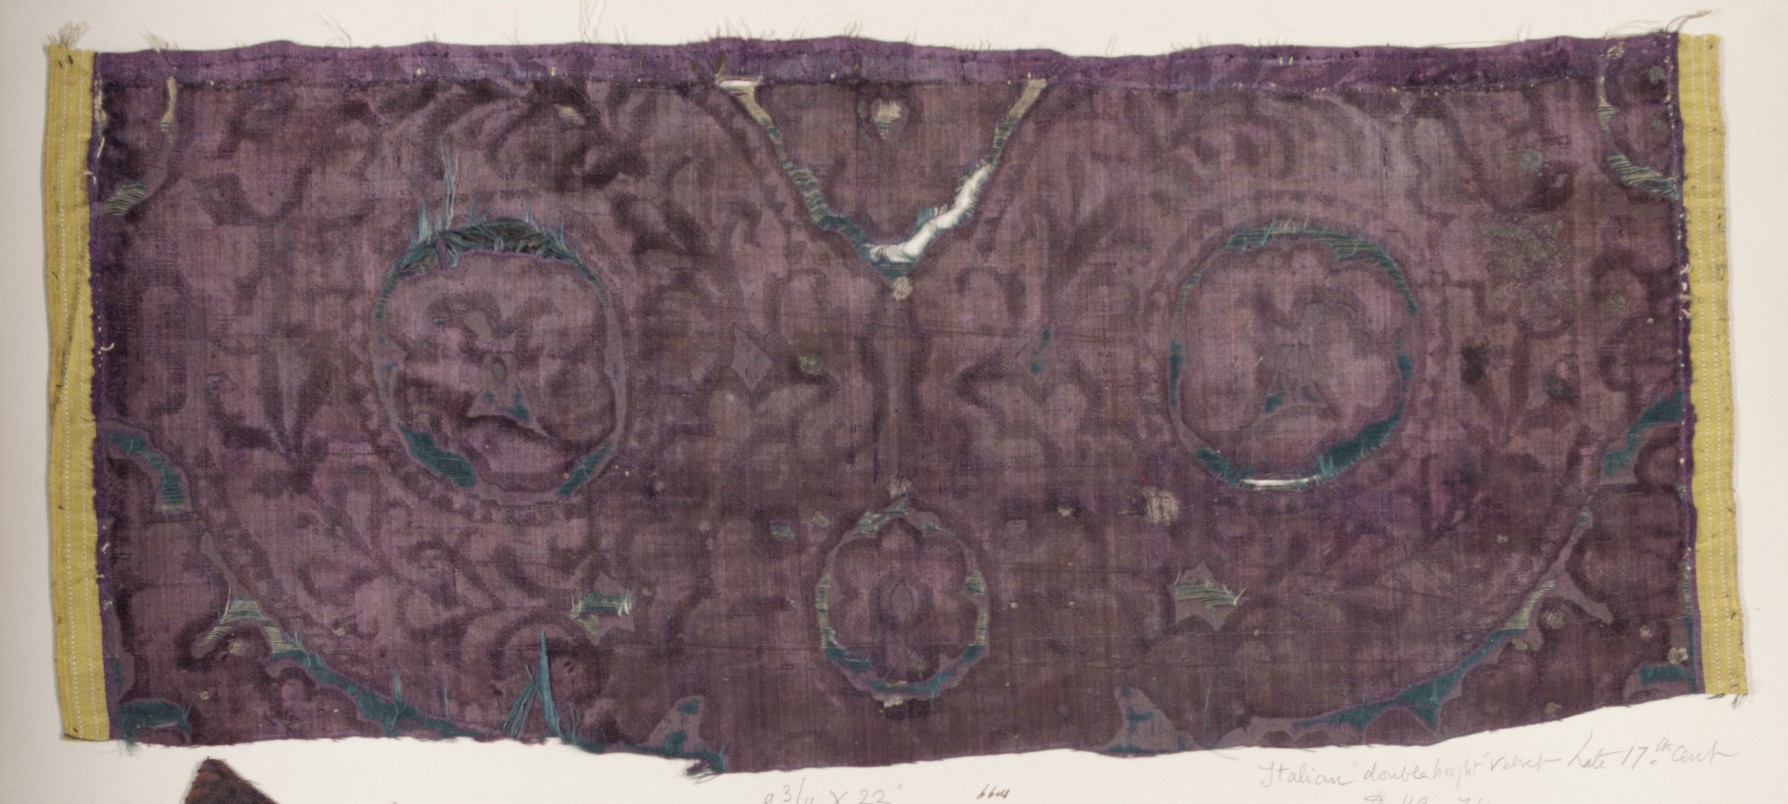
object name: fragment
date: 1667-1700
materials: silk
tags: leaves